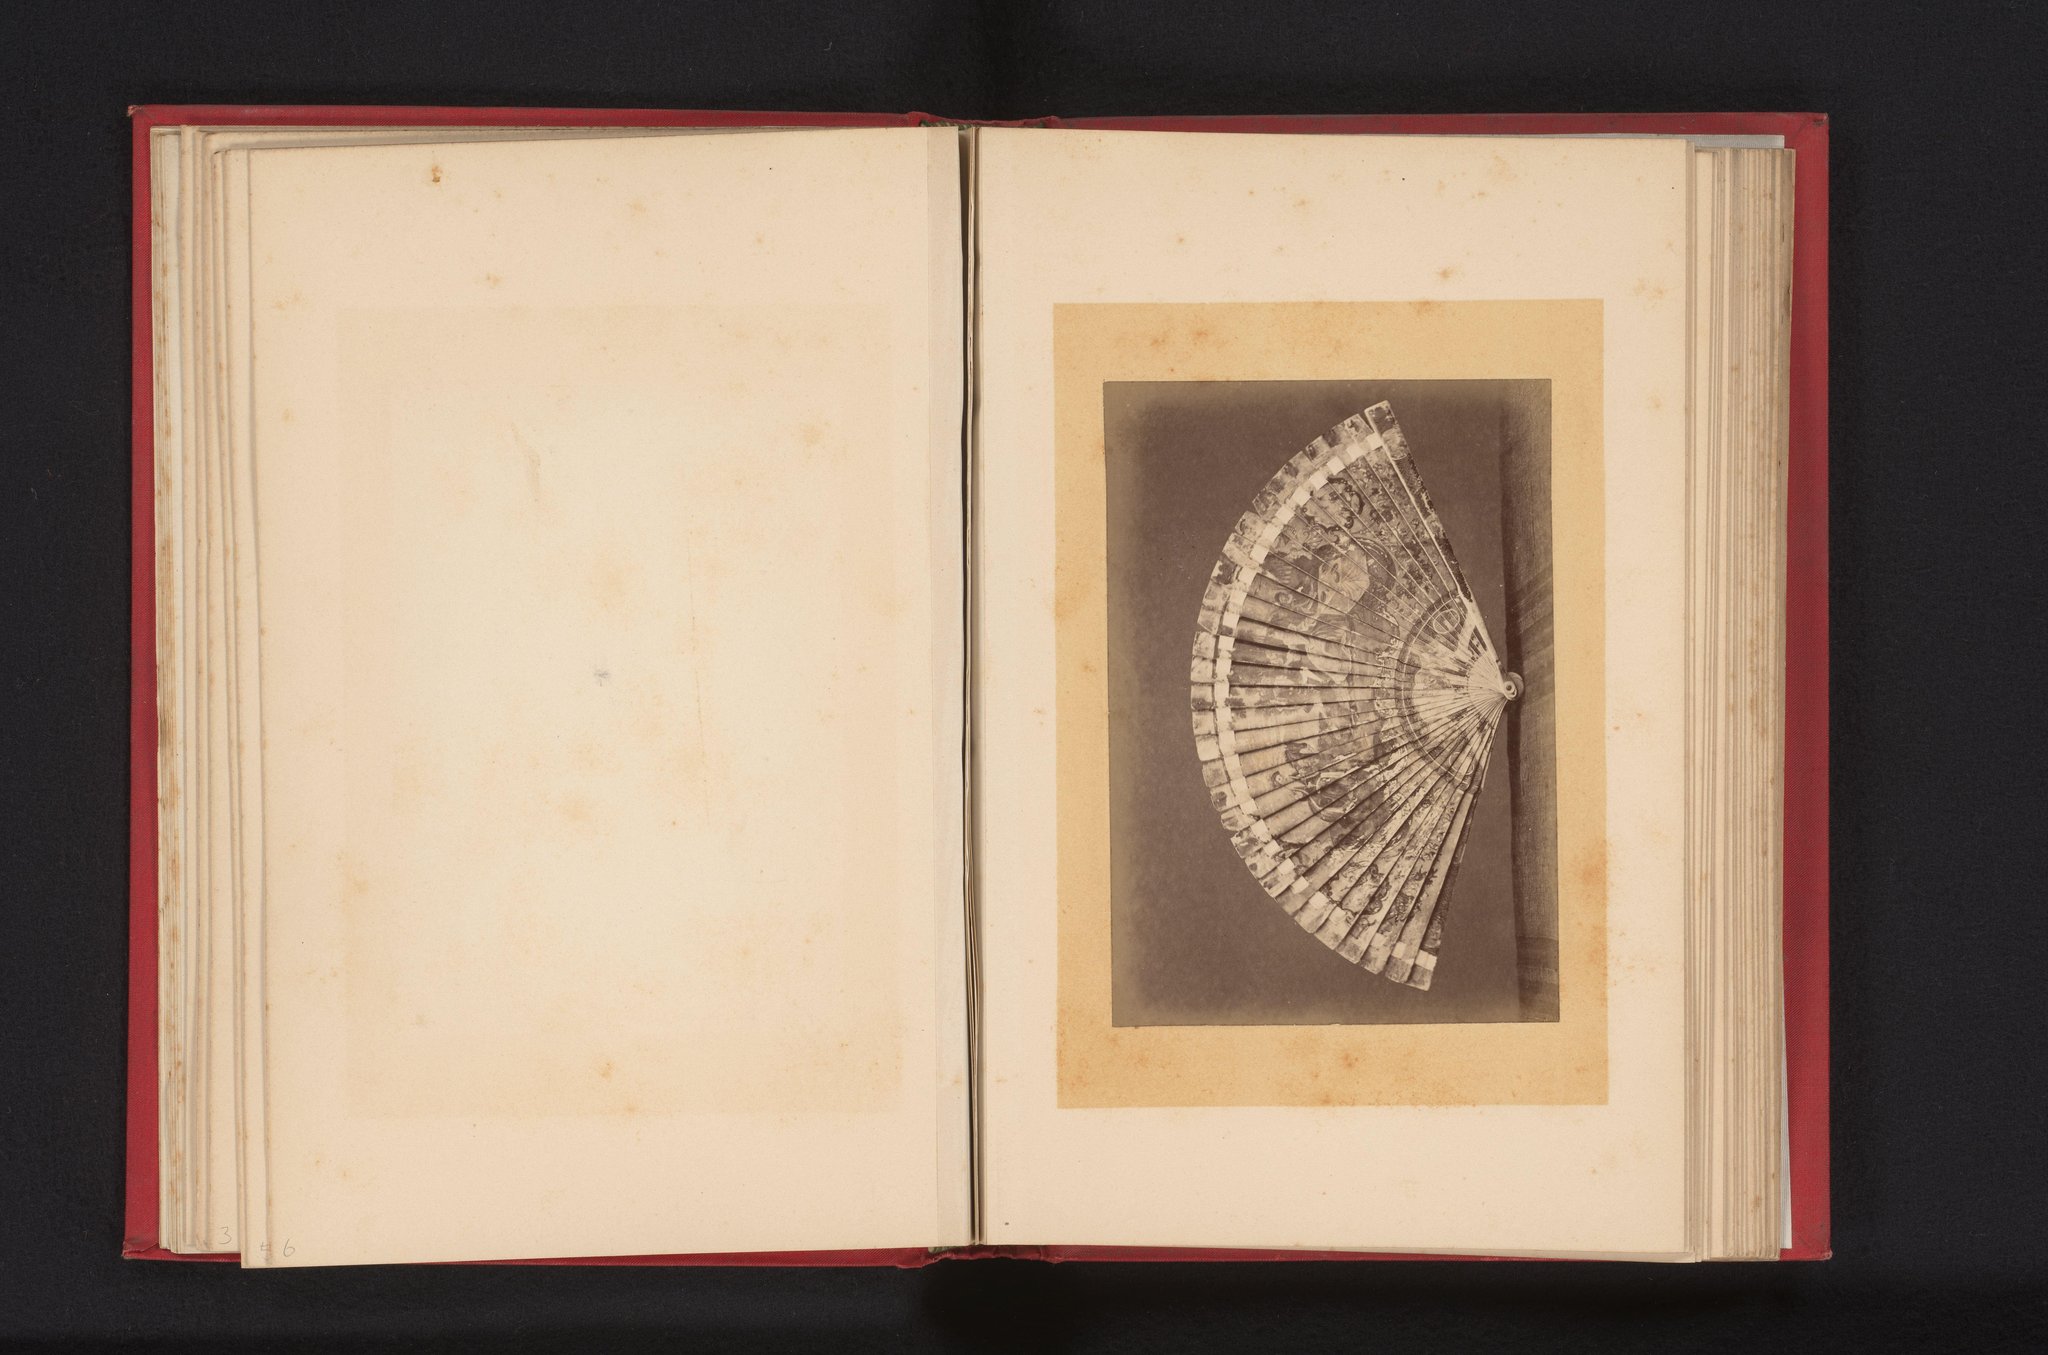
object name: photograph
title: Waaier met illustratie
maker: Anonymous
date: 1872-1878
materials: photographic support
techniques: albumen print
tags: fan